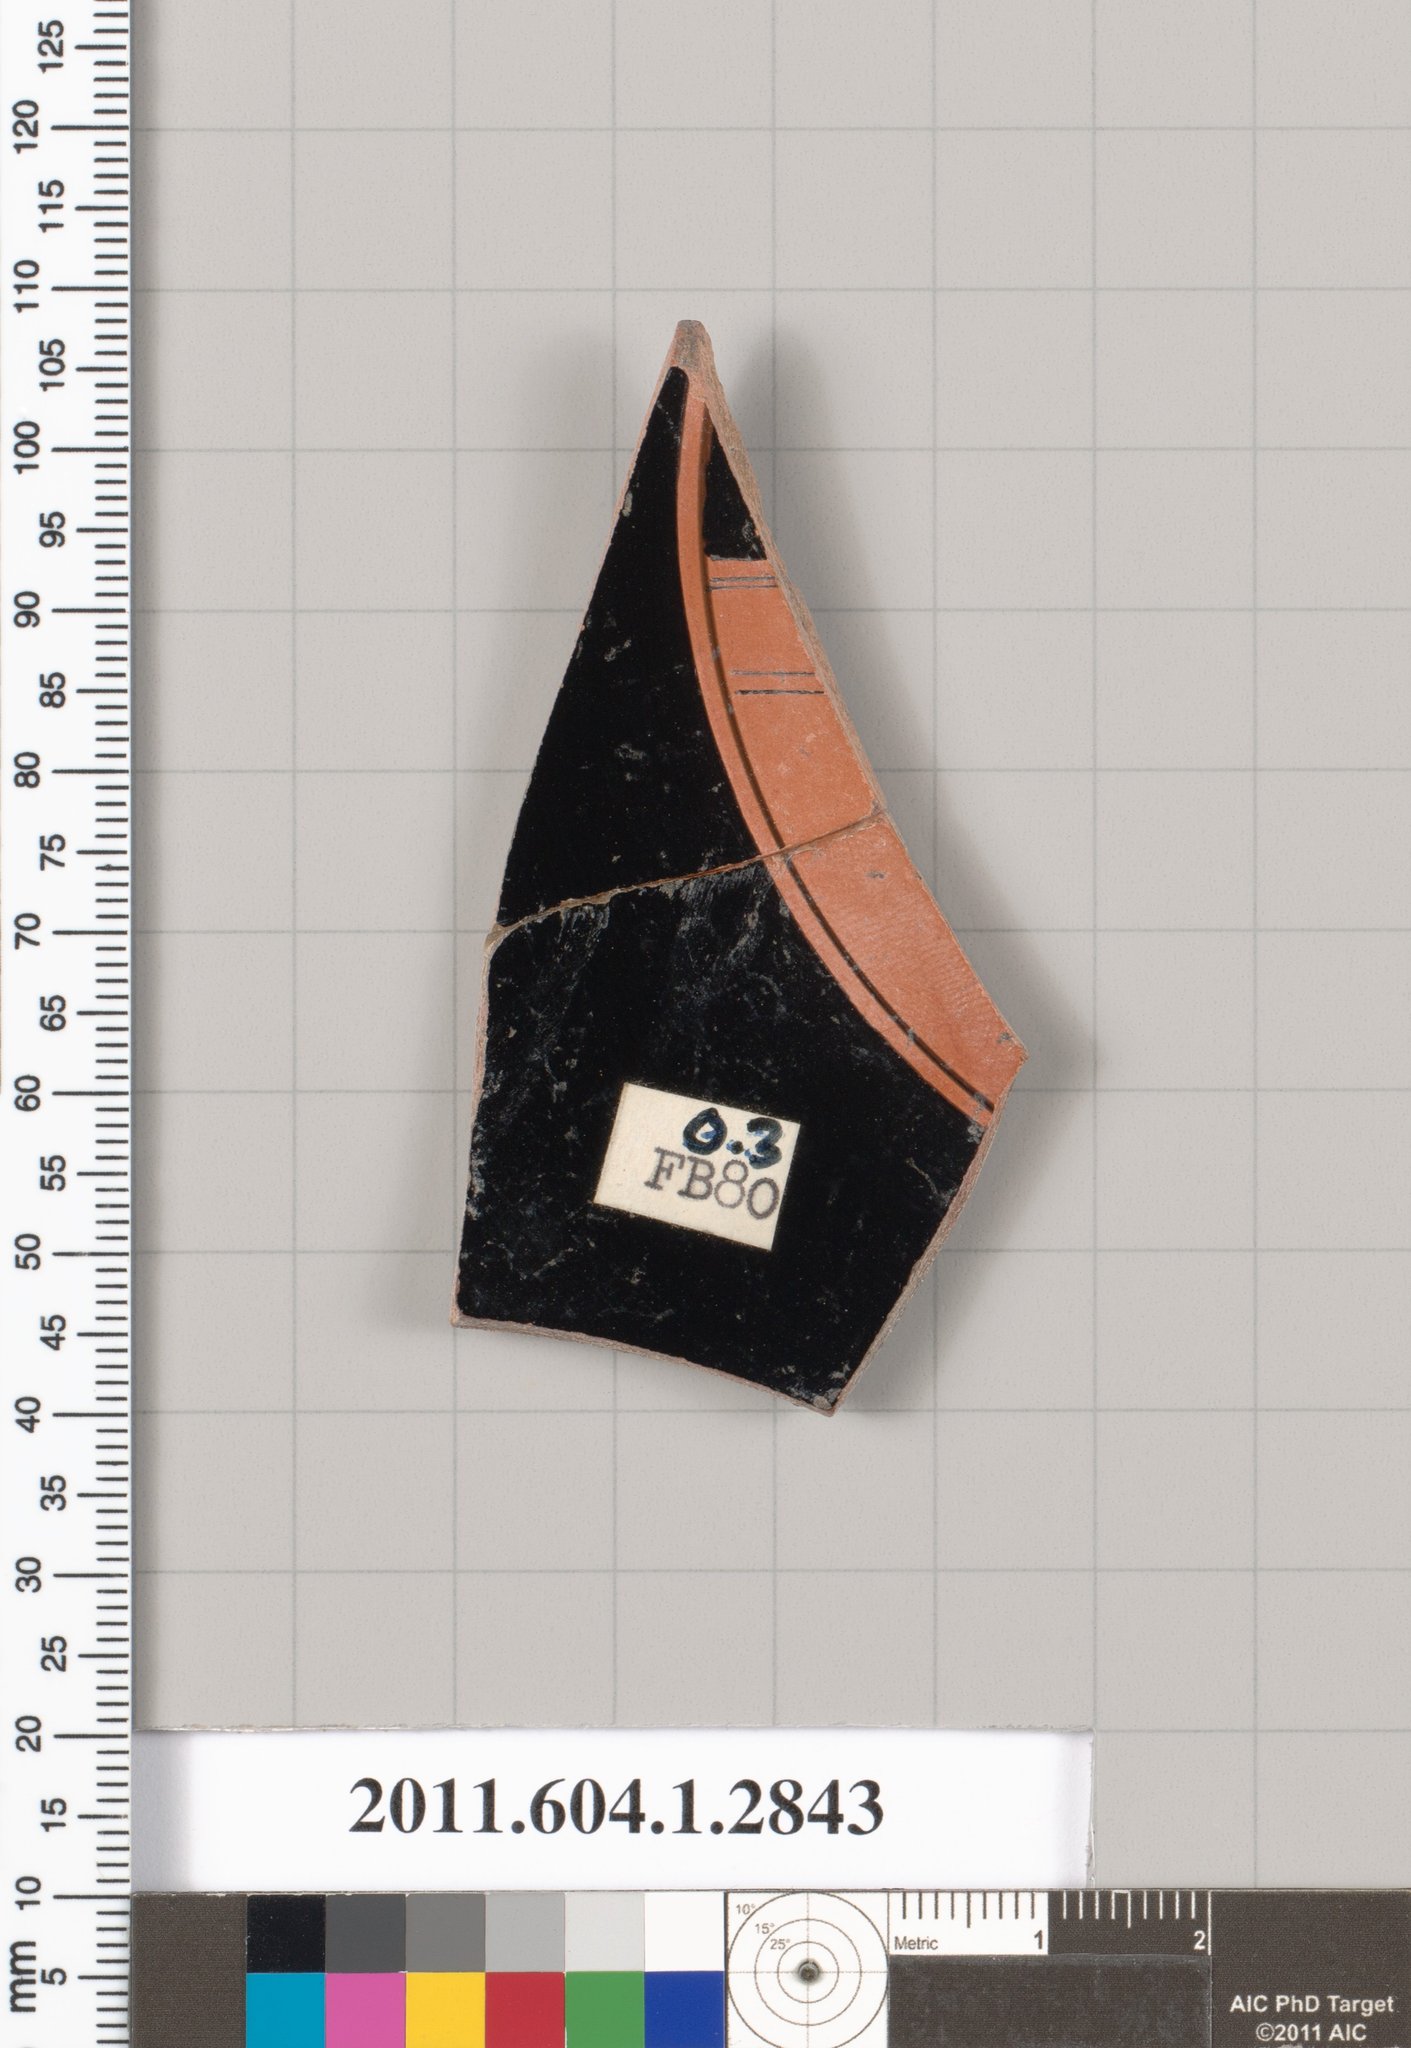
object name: kylix fragment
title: Terracotta fragment of a kylix (drinking cup)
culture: greek, attic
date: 510-490 BCE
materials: terracotta